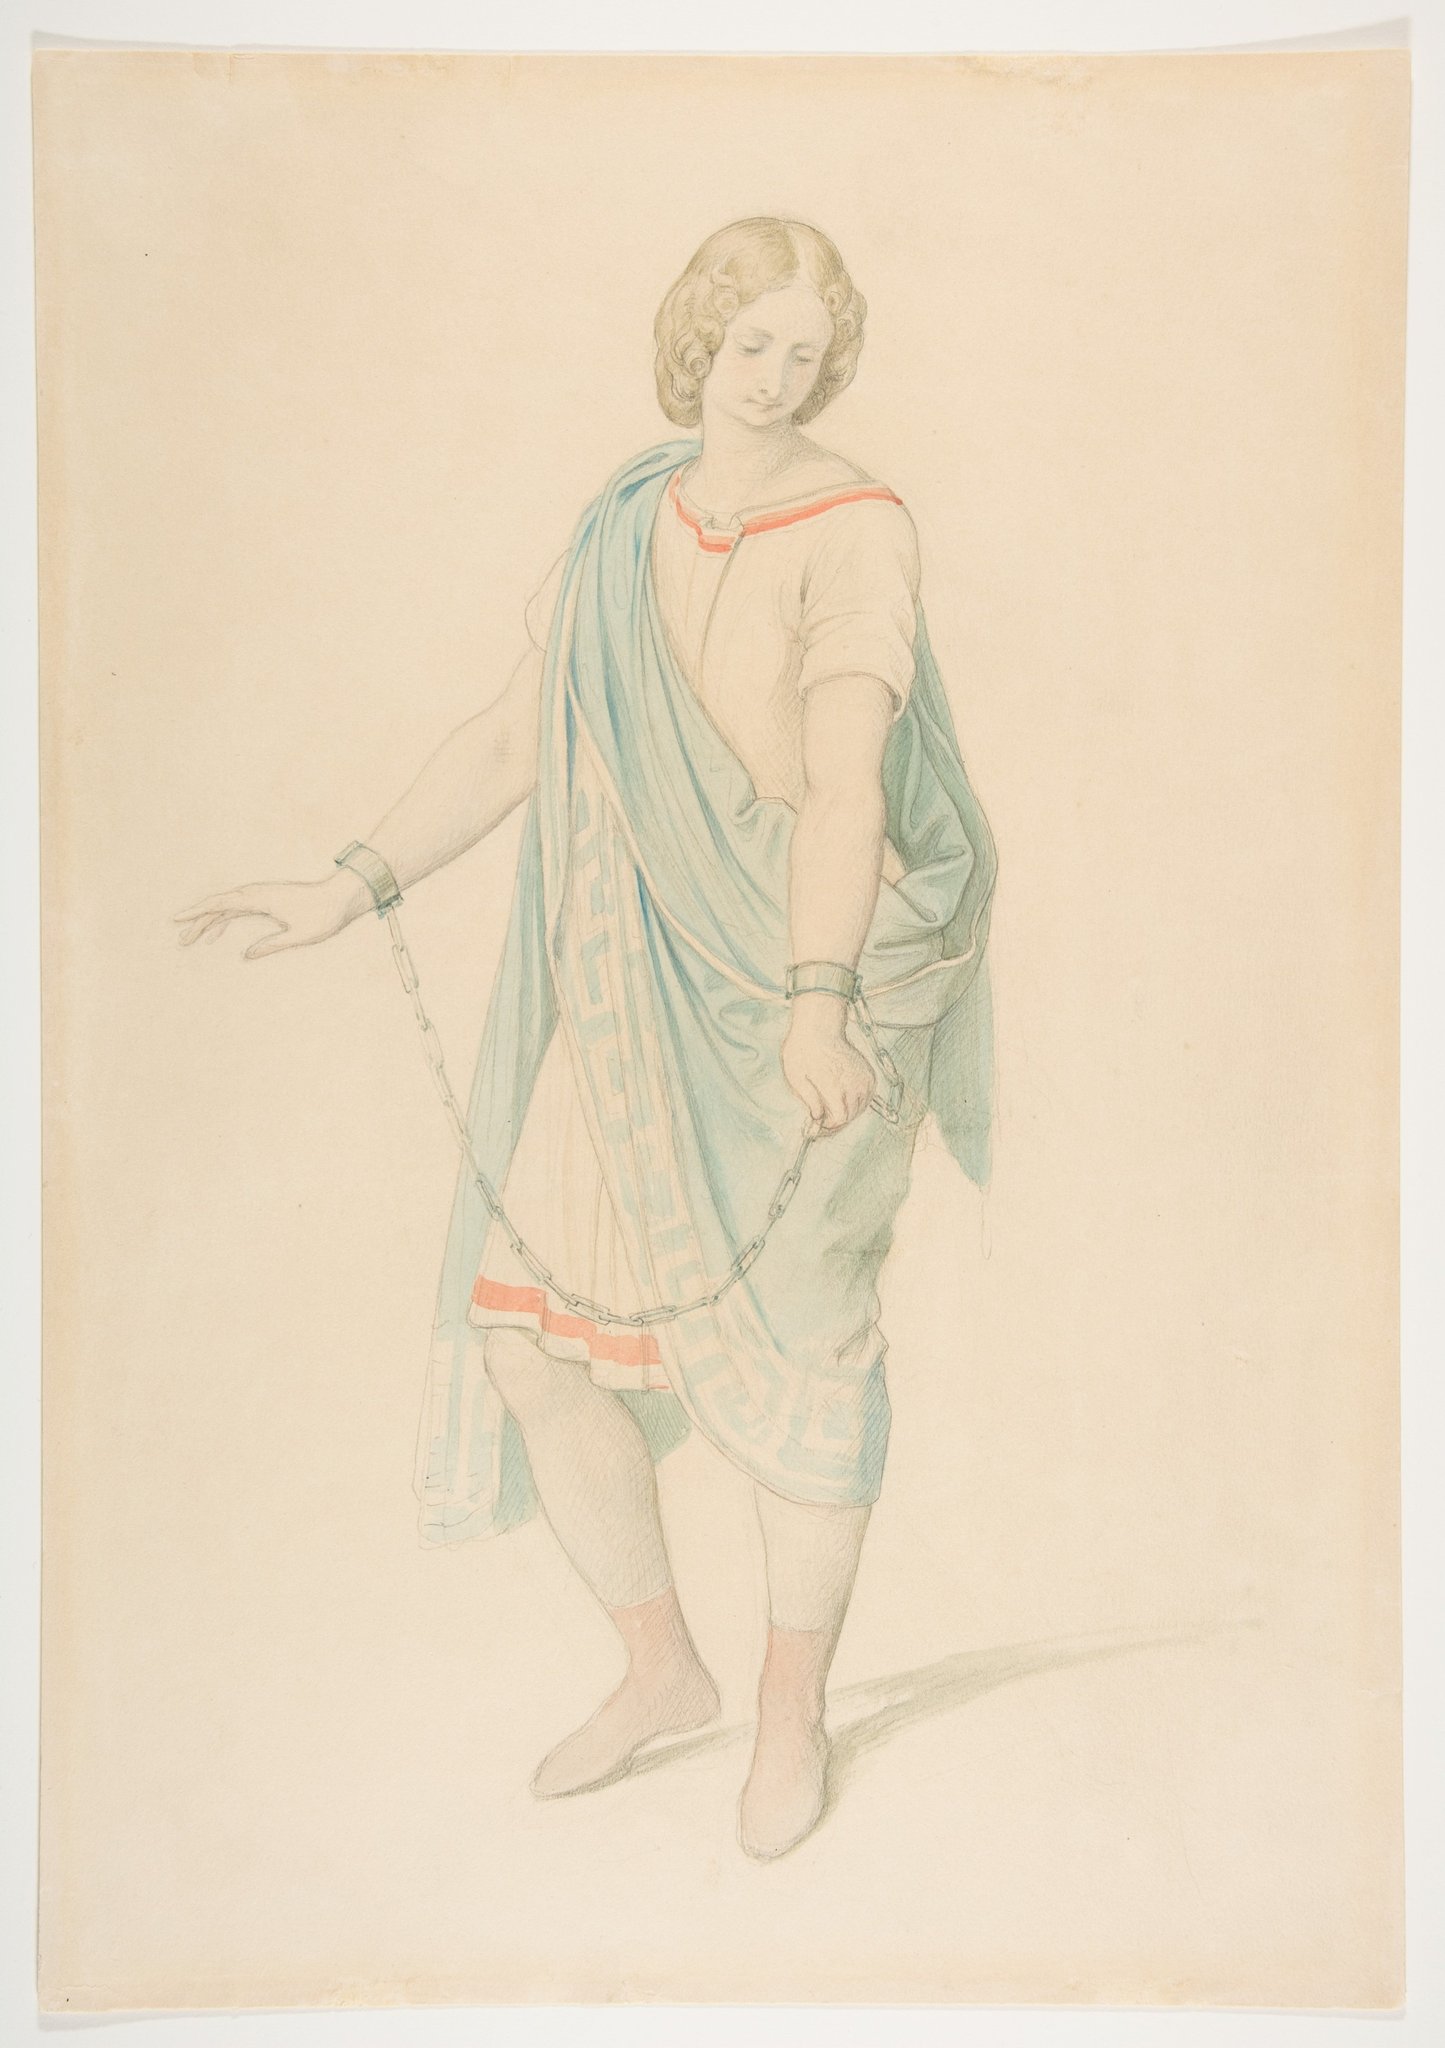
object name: drawing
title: The soprano Karoline Hetzenecker in the role of Sesto in La Clemenza di Tito by W.A. Mozart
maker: moritz von schwind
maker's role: artist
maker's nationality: austrian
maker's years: 1804-1871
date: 1848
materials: graphite, watercolor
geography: germany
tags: women,actresses